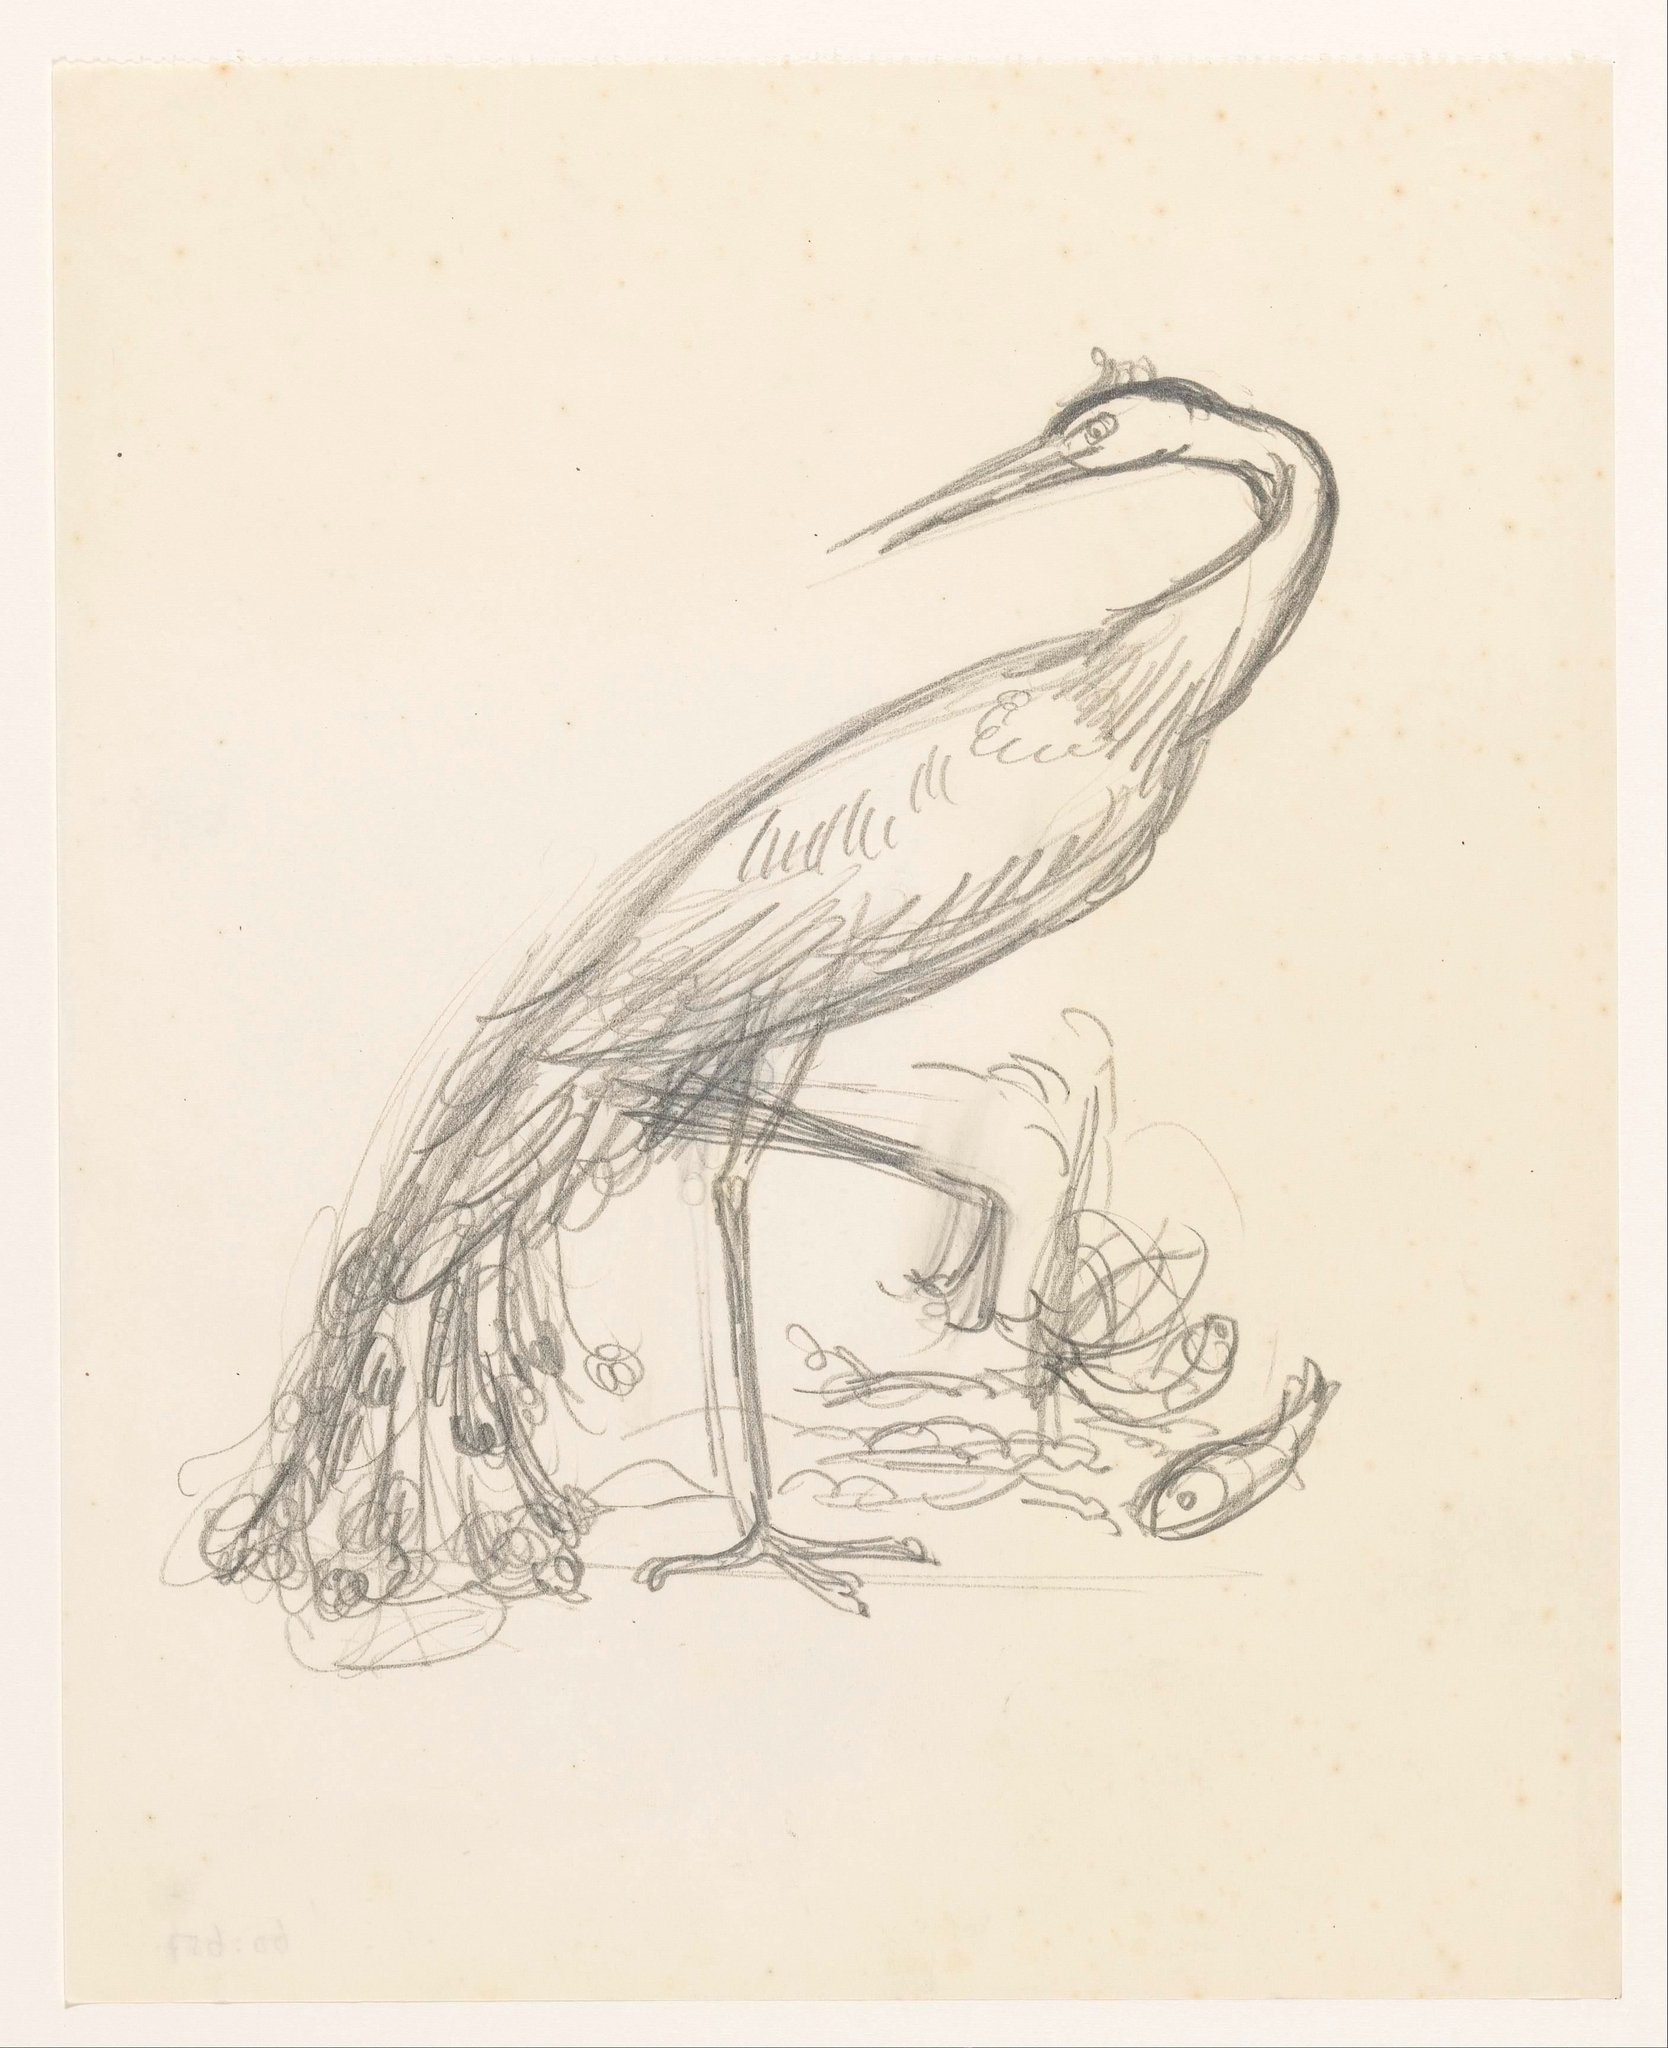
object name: drawing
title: Reiger aan het water met twee vissen bij zijn poten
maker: leo gestel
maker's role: draughtsman, print maker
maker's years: 1881-1941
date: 1891-1941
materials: paper, pencil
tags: shore-birds and wading-birds: heron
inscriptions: collector's mark: Lugt 2228, watermark: ‘GW/ PAPIER/ 1671’